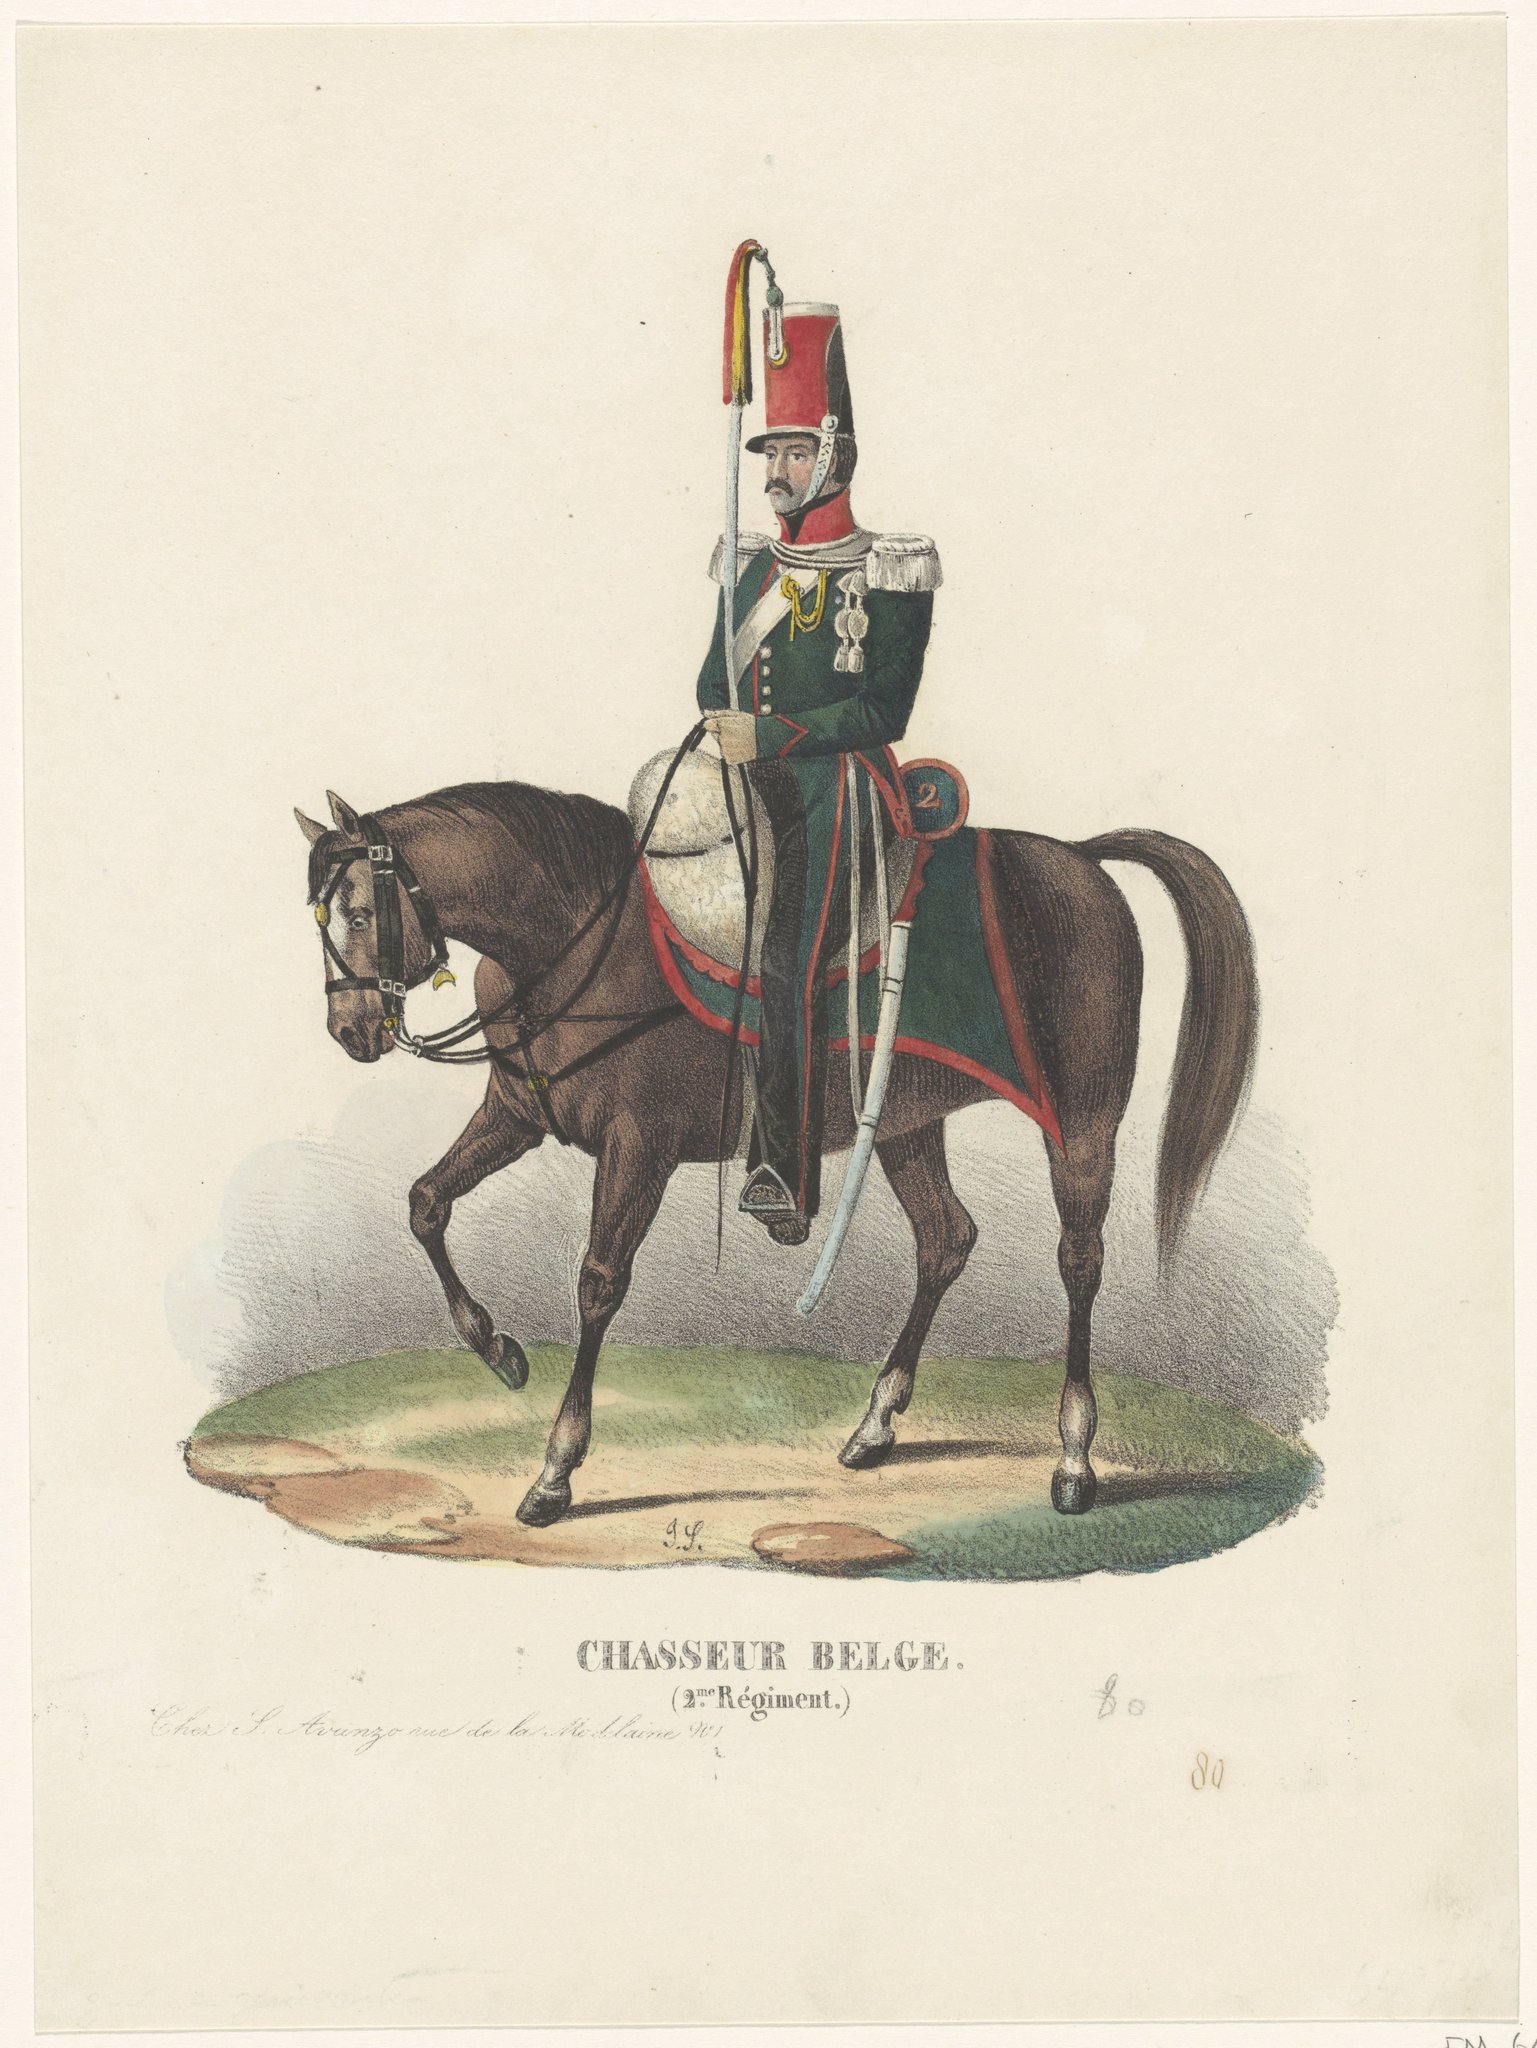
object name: print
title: Belgische vrijwillige jager, 1830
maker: Anonymous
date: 1830-1831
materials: paper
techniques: hand coloring, lithograph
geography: brussels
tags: (military) uniforms, clothes, costume, belgium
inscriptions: collector's mark: Lugt 2228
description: Een Belgische vrijwillige jager van het 2e Regiment, 1830, te paard. Onderdeel van een groep voorstellingen van Belgische uniformen.